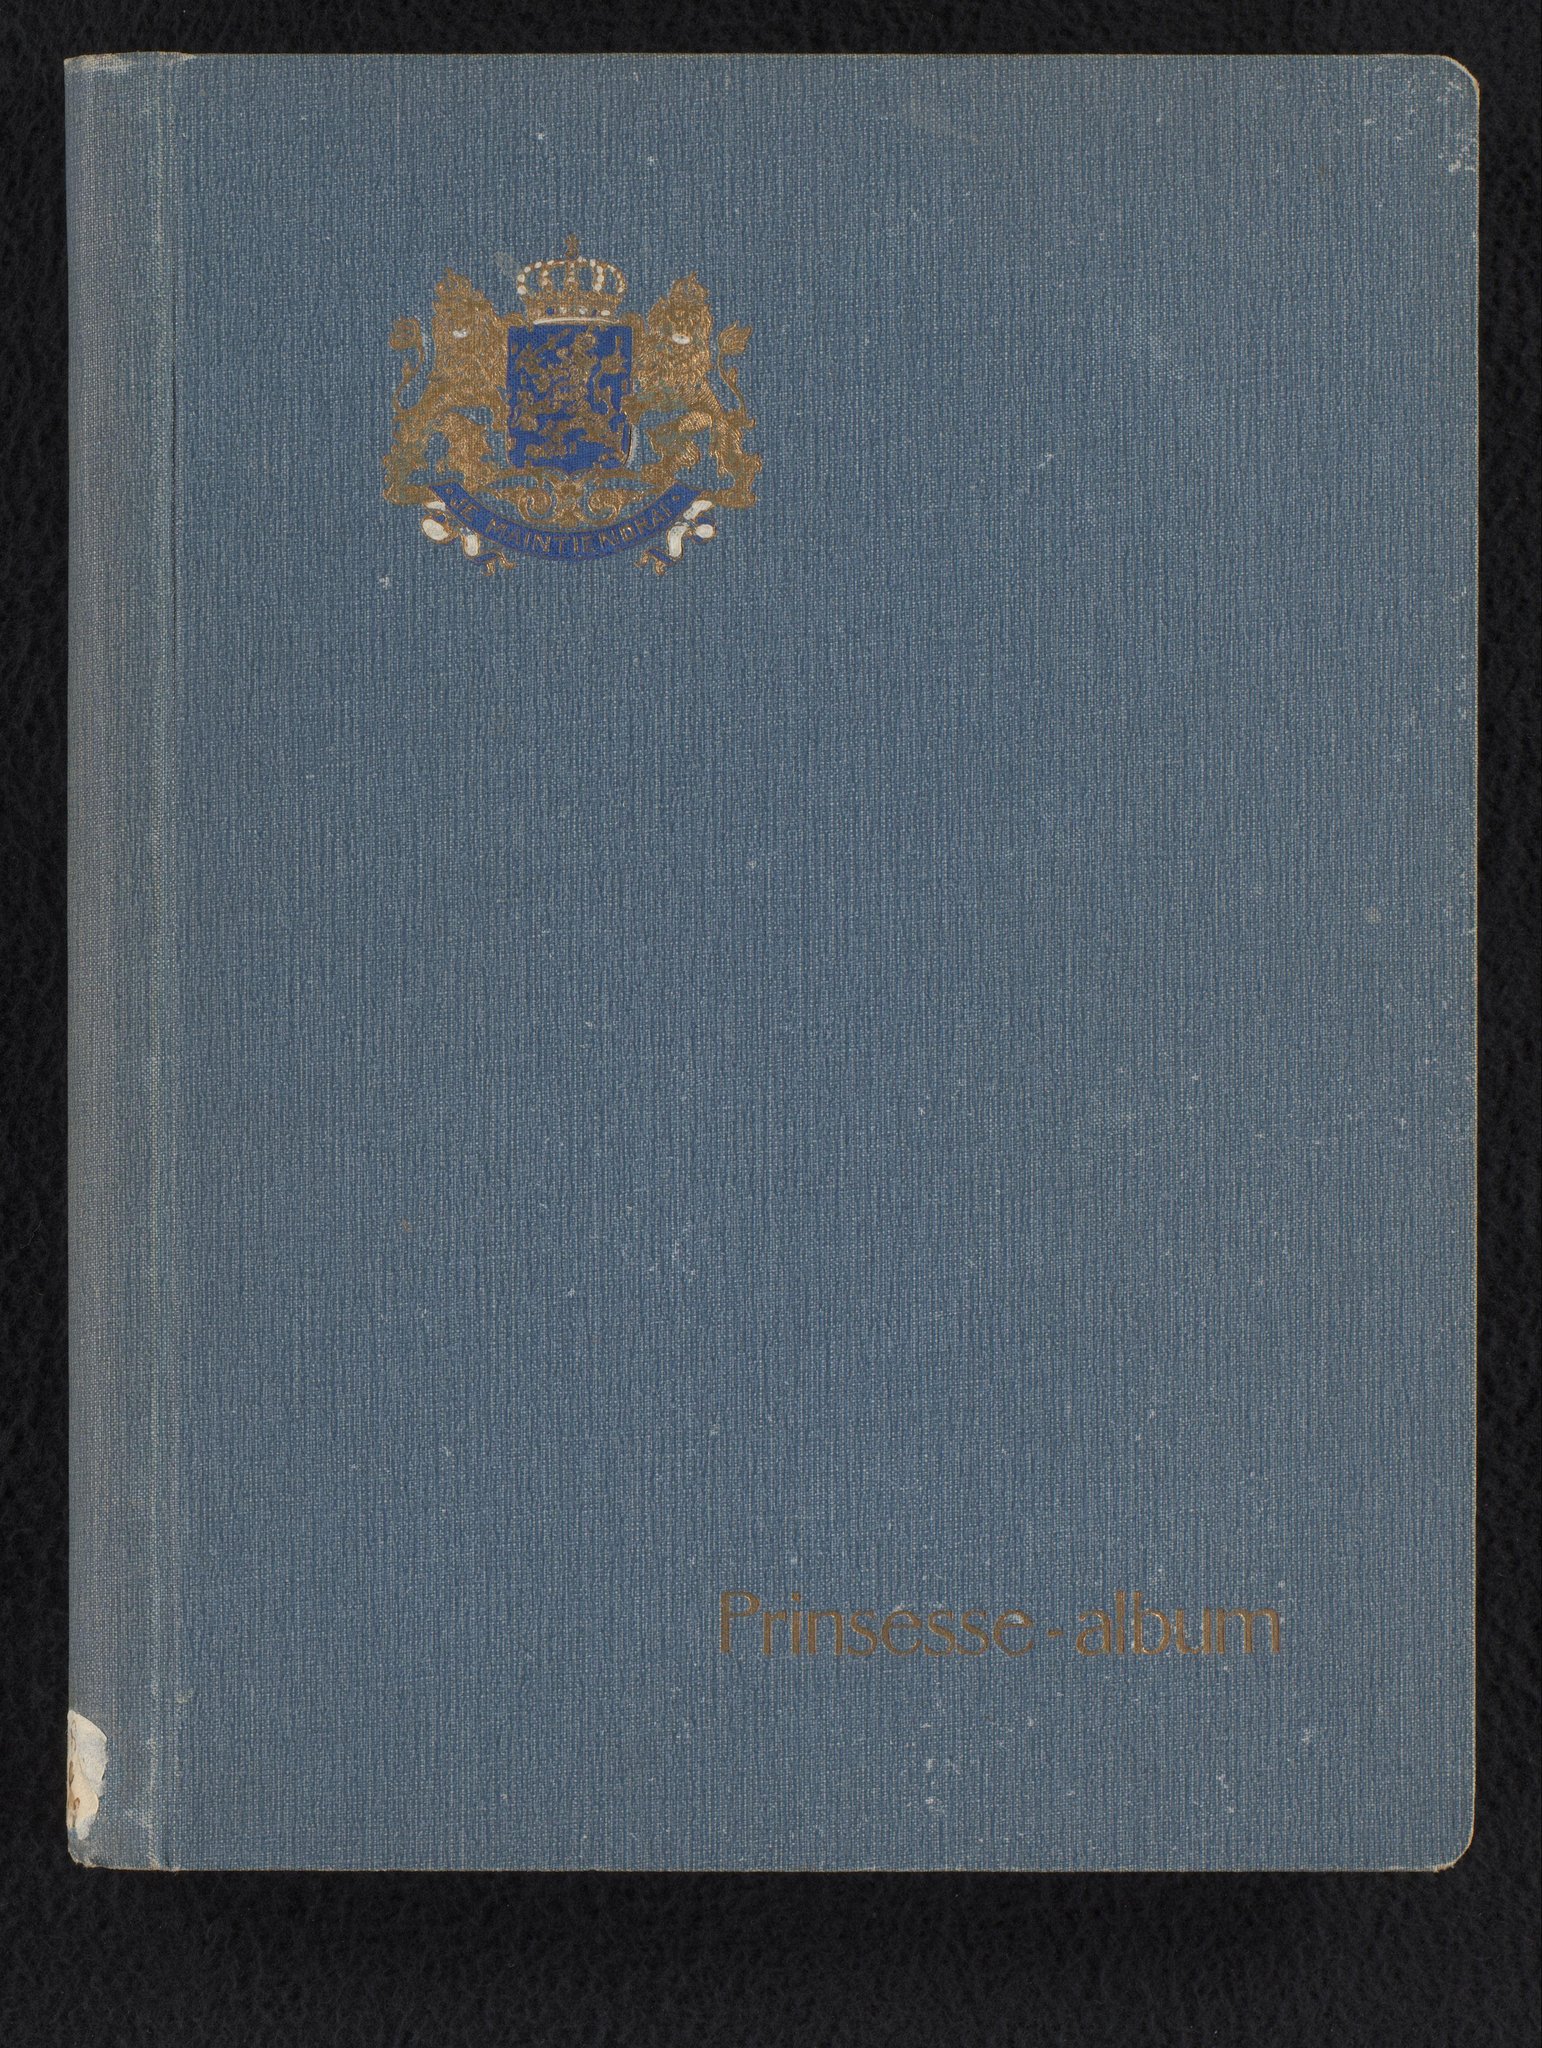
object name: slip in album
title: Prinsesse-album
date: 1898-1925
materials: cardboard, linen, paper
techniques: photograph, gelatin silver print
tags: the hague, print maker, wilhelmina of the netherlands, juliana of the netherlands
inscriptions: collector's mark: Lugt 2166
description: Insteekalbum met prentbriefkaarten van koningin Wilhelmina en prinses Juliana. Het album bevat 38 fotomechanische afdrukken en 37 foto's.